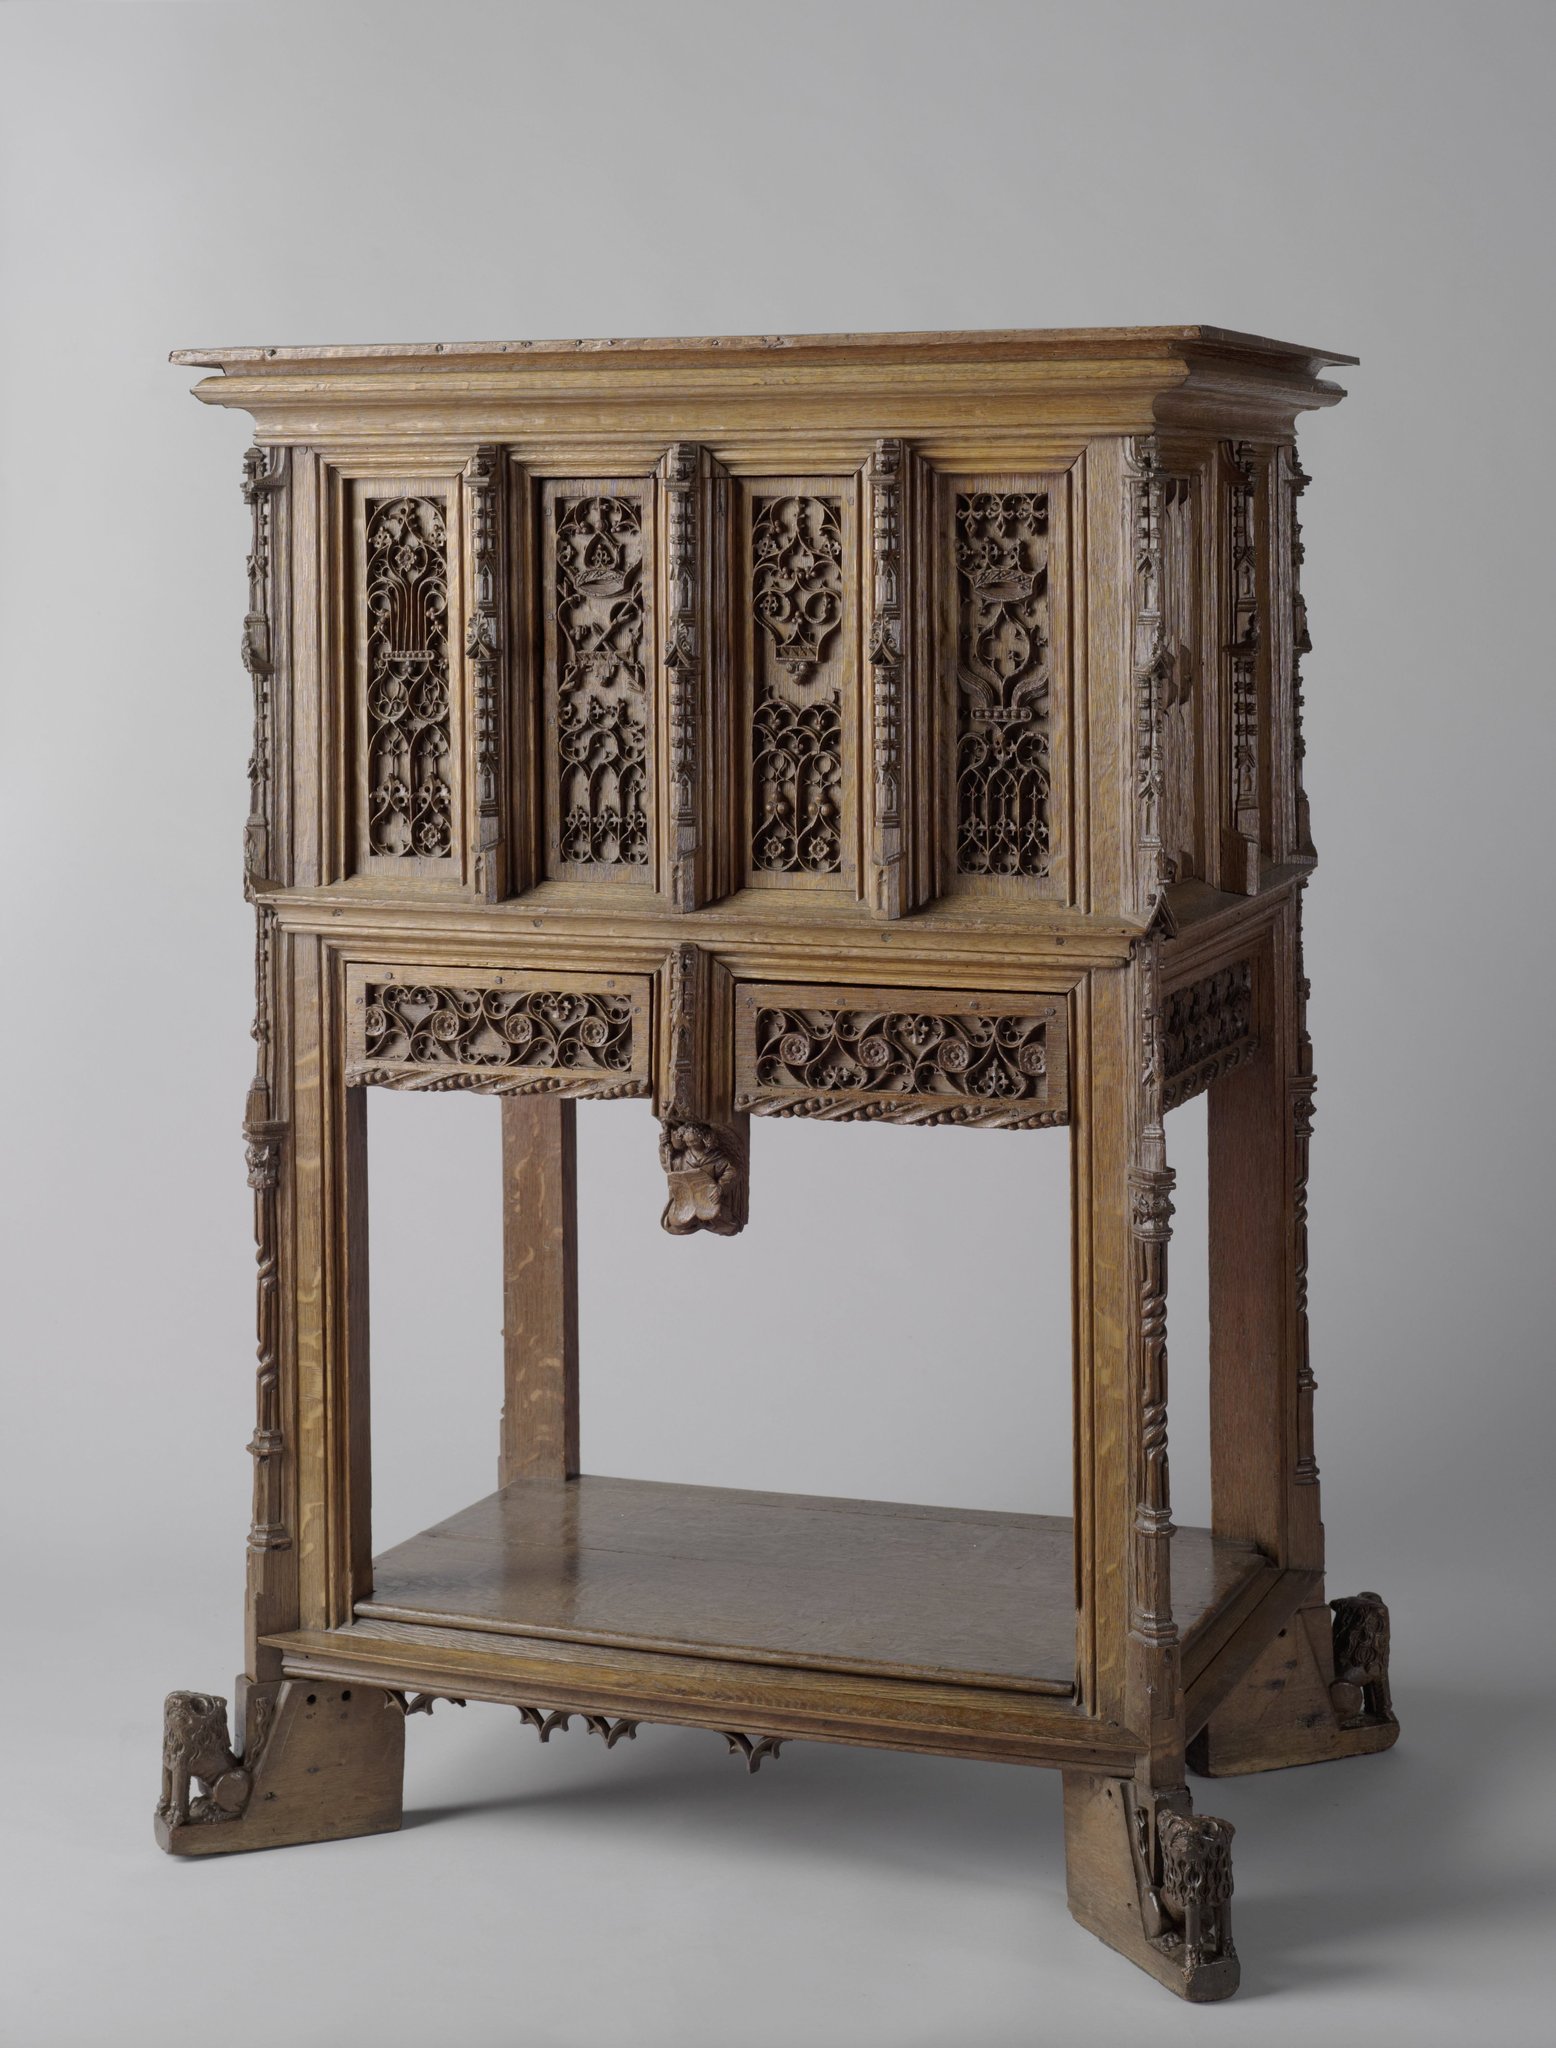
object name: furniture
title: Cabinet of a Militia Company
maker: Anonymous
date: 1520-1530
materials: wood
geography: alkmaar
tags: ghent, charles v (holy roman emperor and king of spain), crown (symbol of sovereignty), angel(s) with other object(s), e.g. weapons, beasts of prey, predatory animals: lion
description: This cabinet would have held a militia company’s valuables, such as drinking cups and guild chains. The imperial crown and the lily on the front panels pay homage to the sovereign, Emperor Charles V. Richly decorated and well preserved, this Gothic-style cabinet is considered one of the finest pieces of 16th-century furniture in the world.